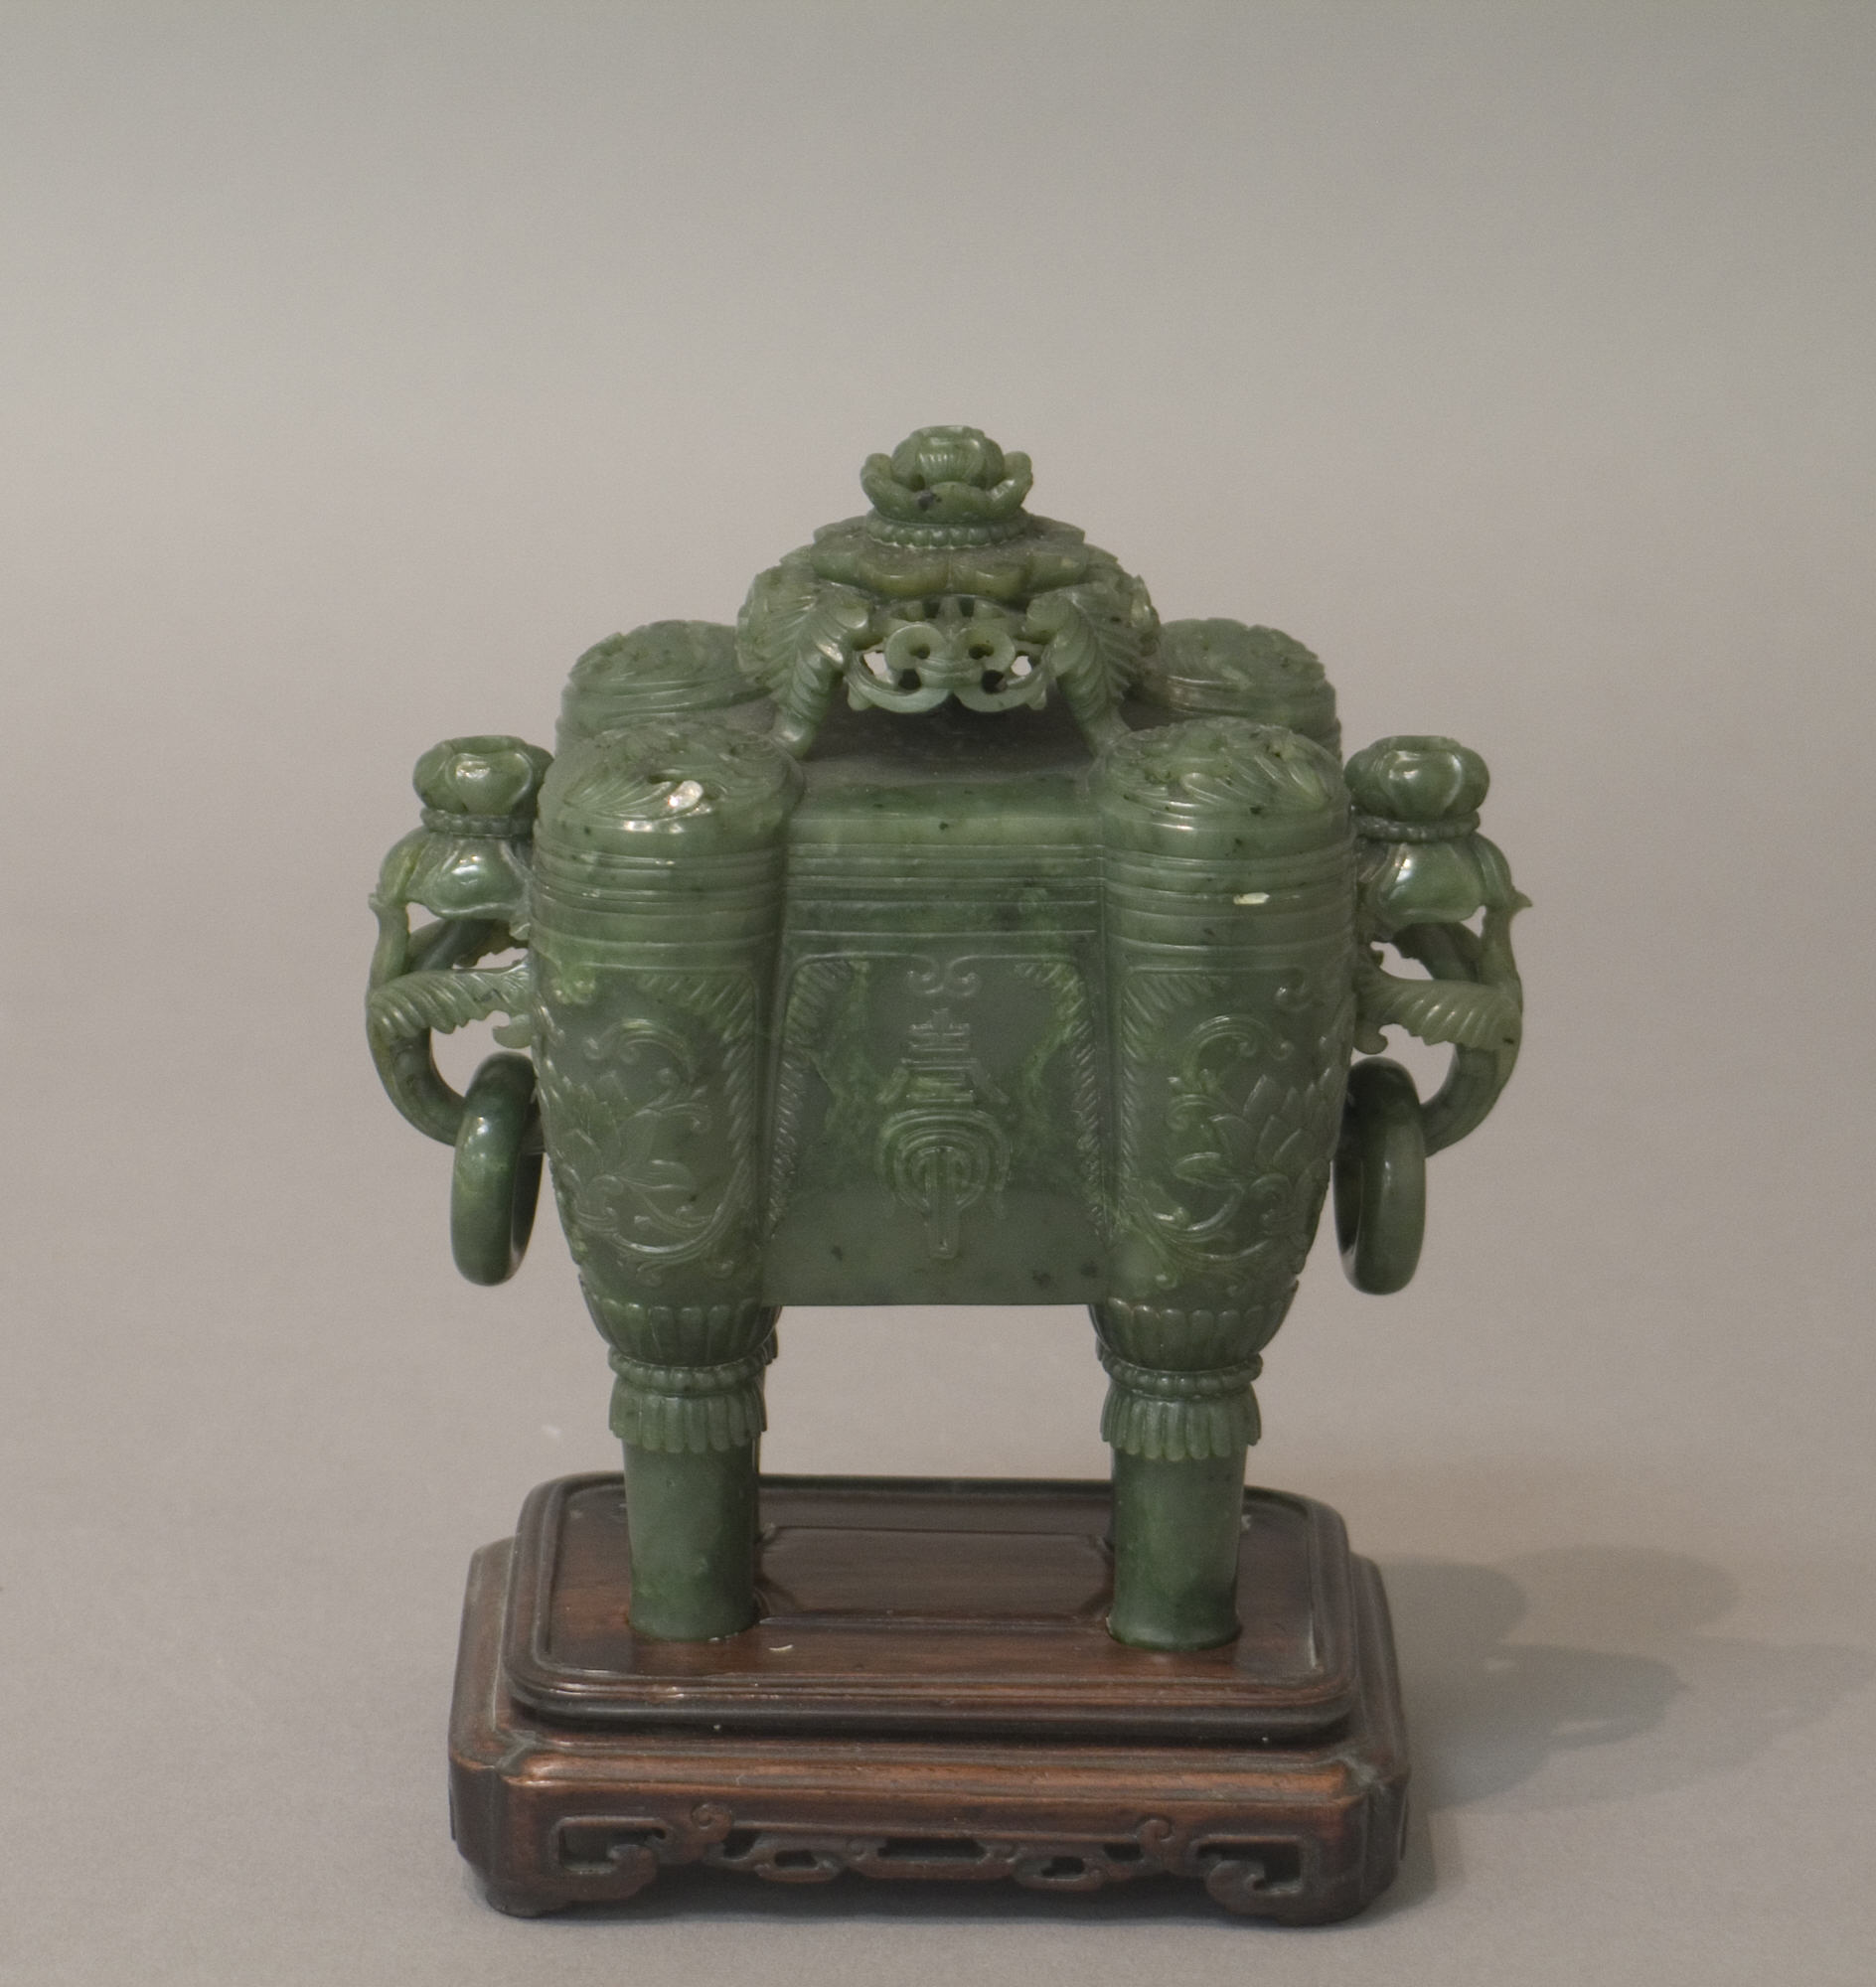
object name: incense burner with cover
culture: chinese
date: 1736-1795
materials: jade